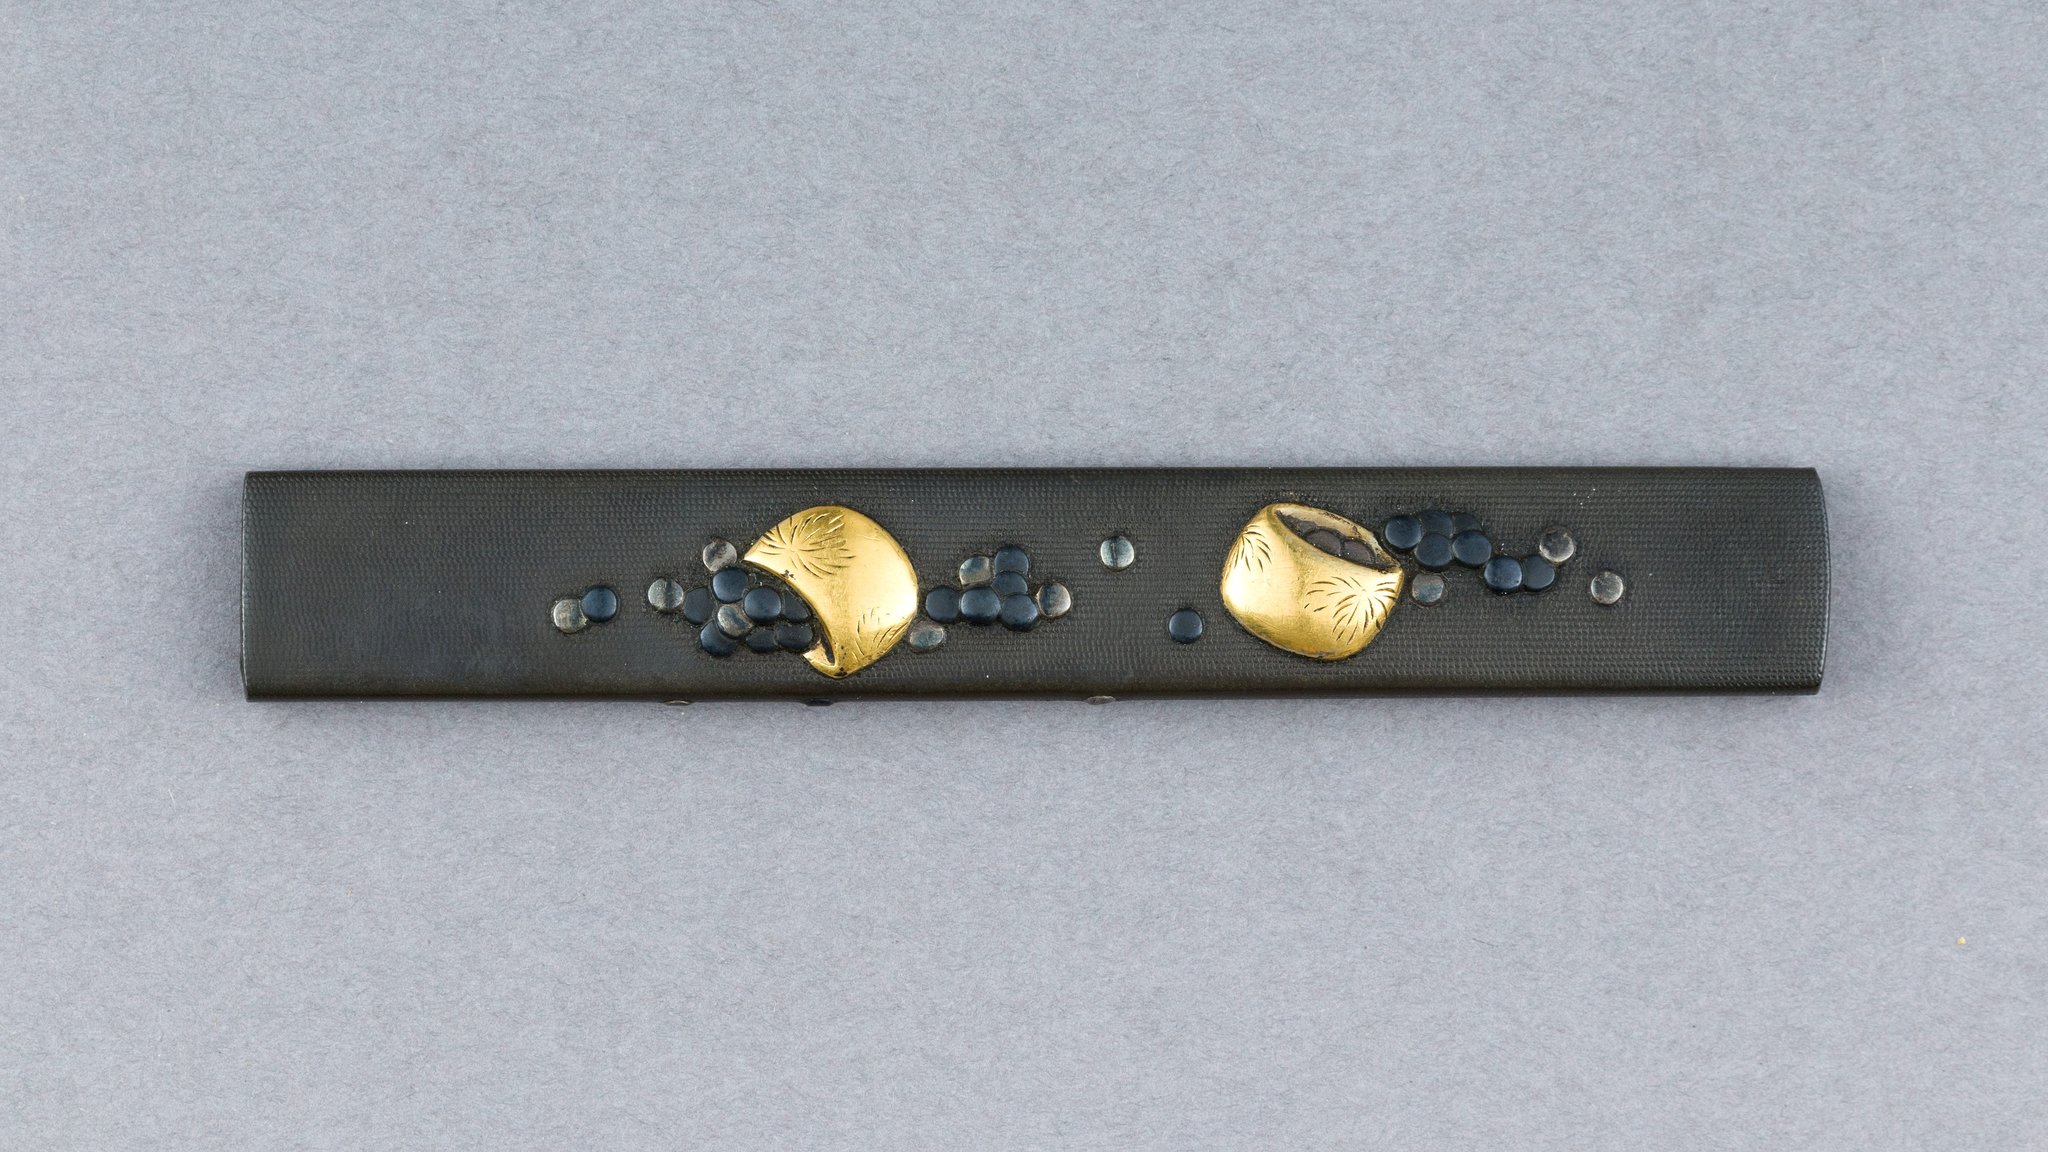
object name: knife handle kozuka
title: Knife Handle (Kozuka)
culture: japanese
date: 1615-1868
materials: gold alloy, silver alloy, gold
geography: japan